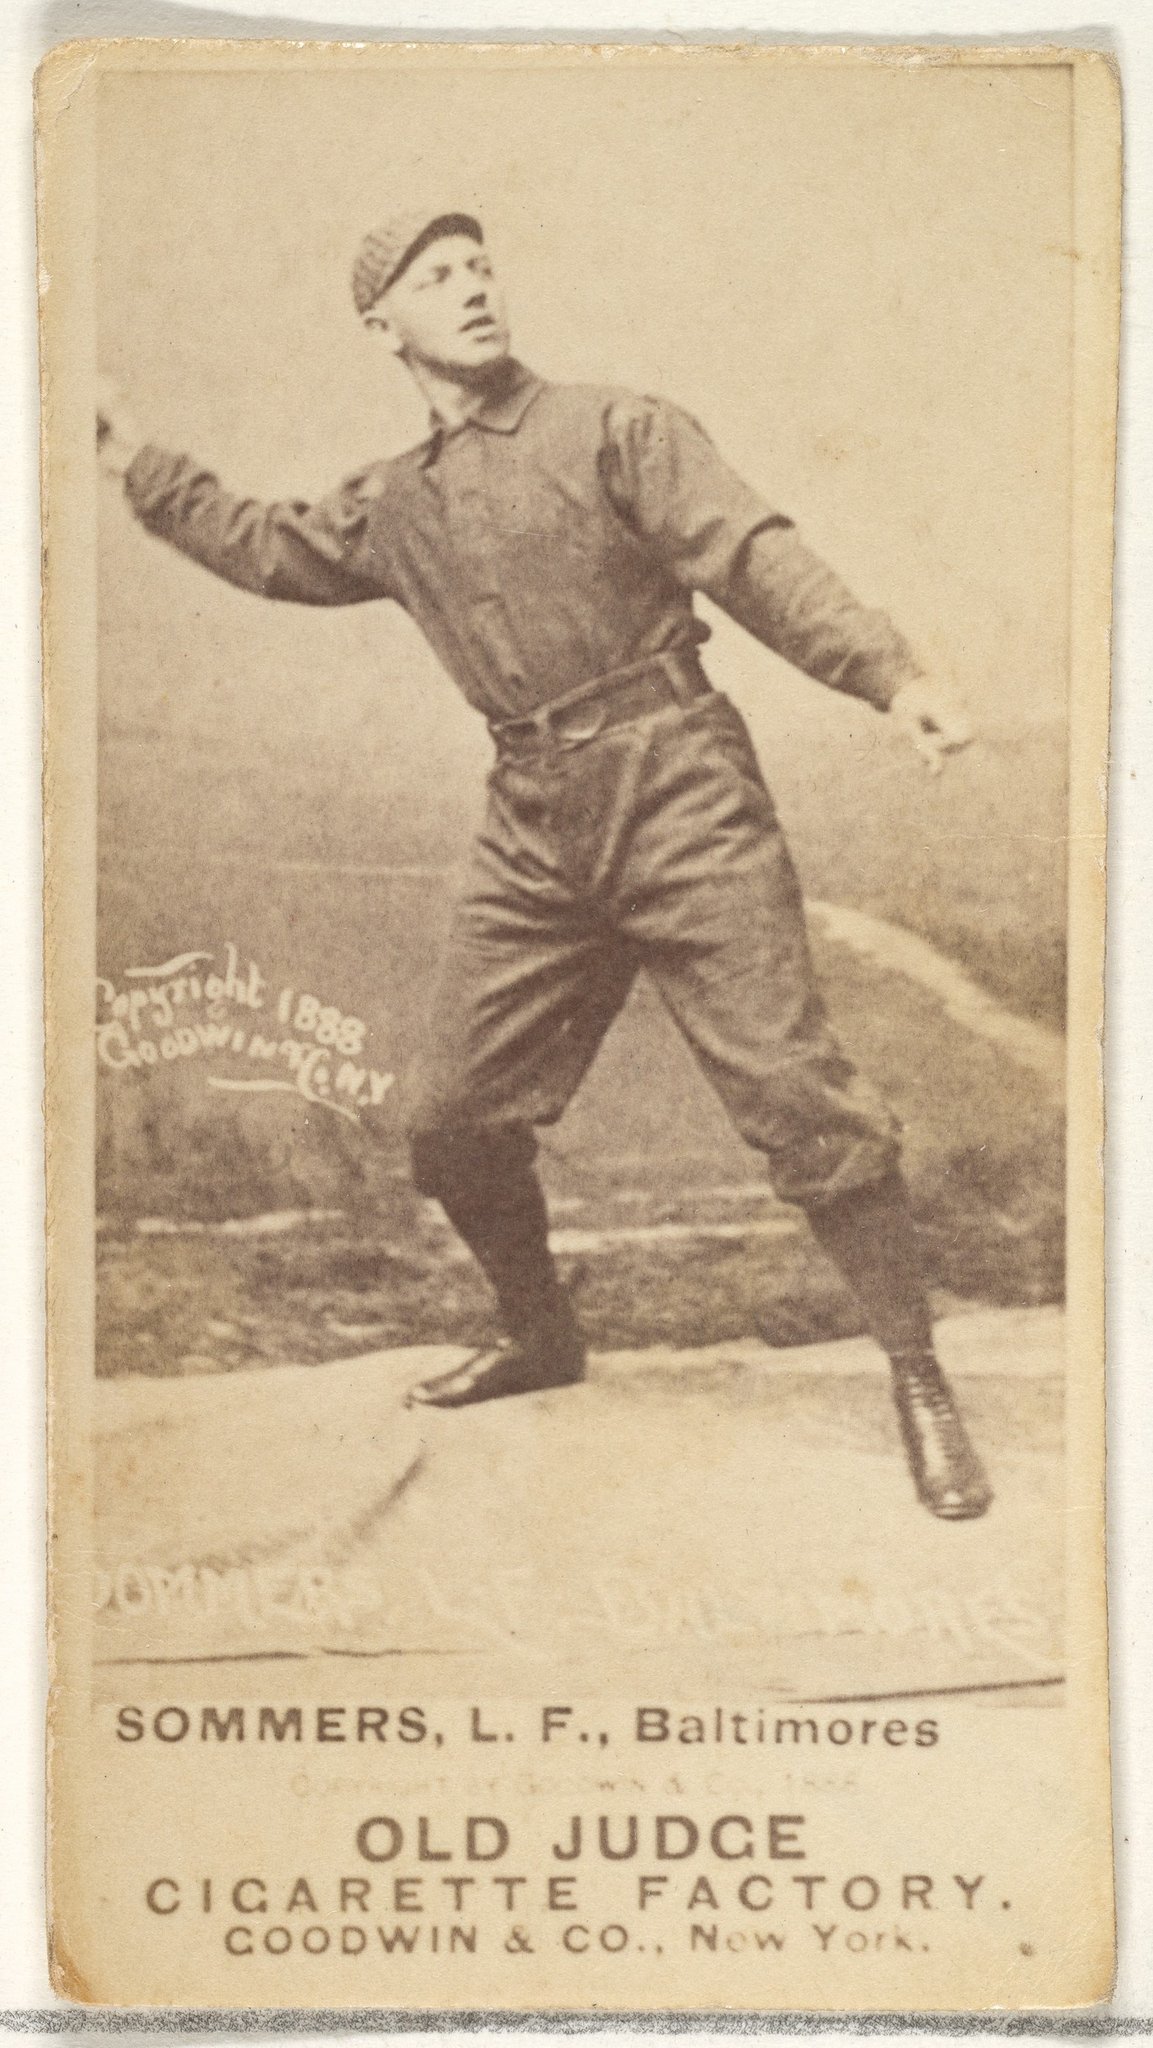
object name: baseball card, photograph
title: Sommers, Left Field, Baltimore Orioles, from the Old Judge series (N172) for Old Judge Cigarettes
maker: goodwin & company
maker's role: publisher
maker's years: 1850-1950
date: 1888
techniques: albumen silver print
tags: men,portraits,baseball,athletes